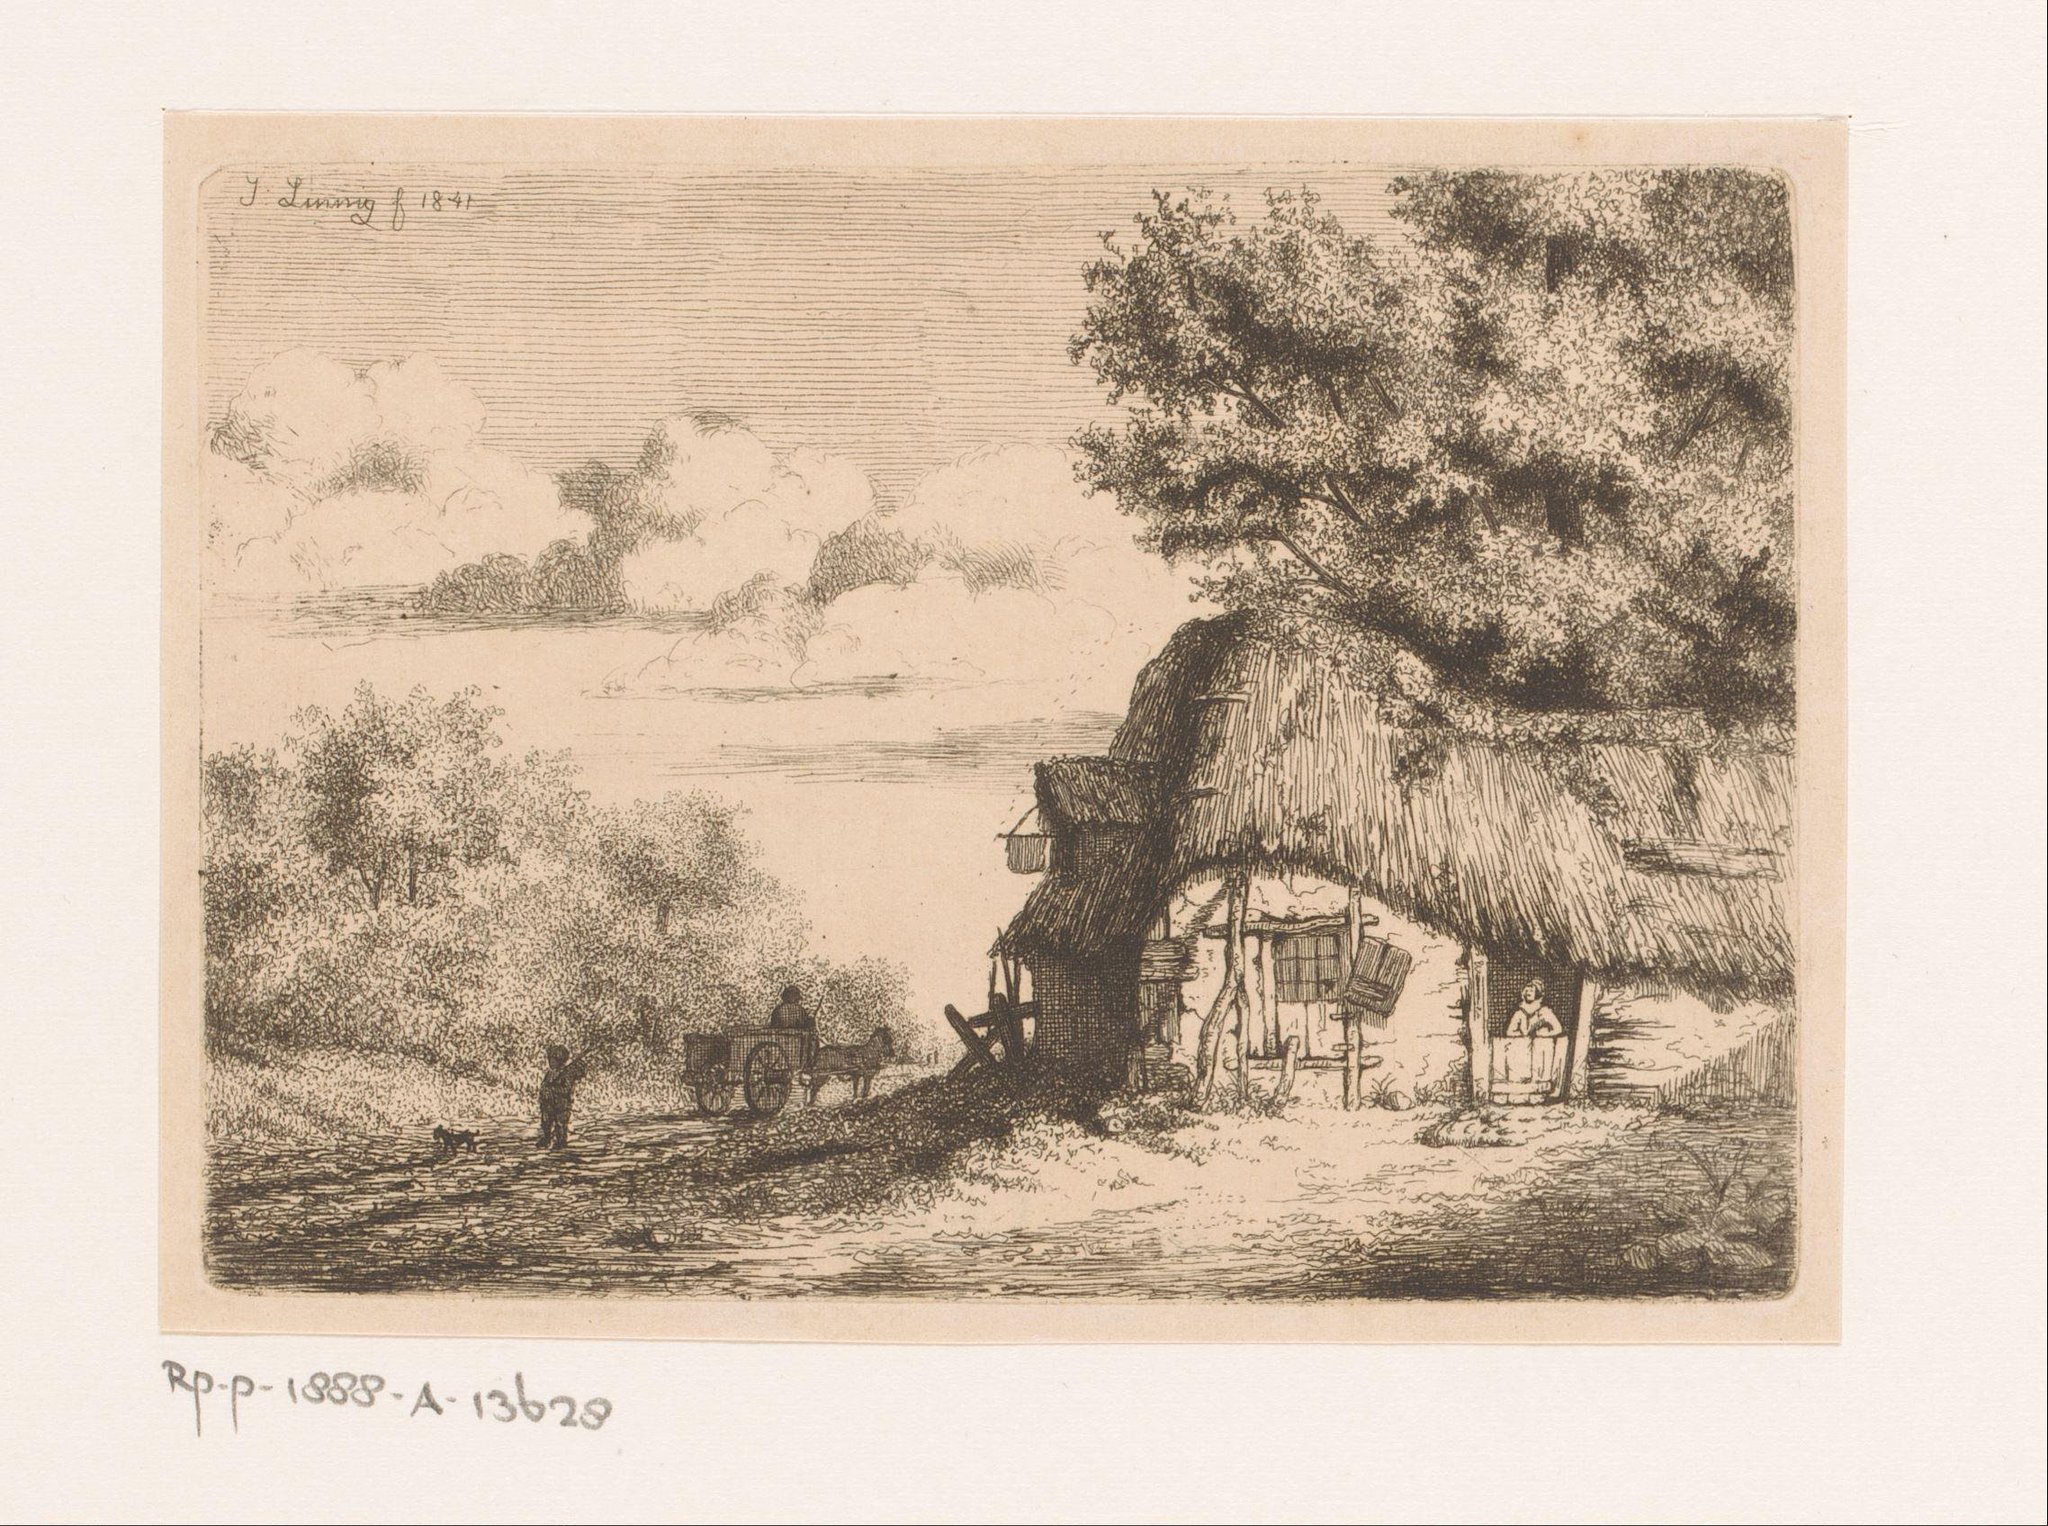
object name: print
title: Boerderij bij Brasschaat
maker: jean théodore joseph linnig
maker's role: draughtsman, print maker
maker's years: 1815-1891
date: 1841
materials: paper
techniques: etching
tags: two-wheeled vehicle drawn by one animal, farm or solitary house in landscape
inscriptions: collector's mark: Lugt 2228